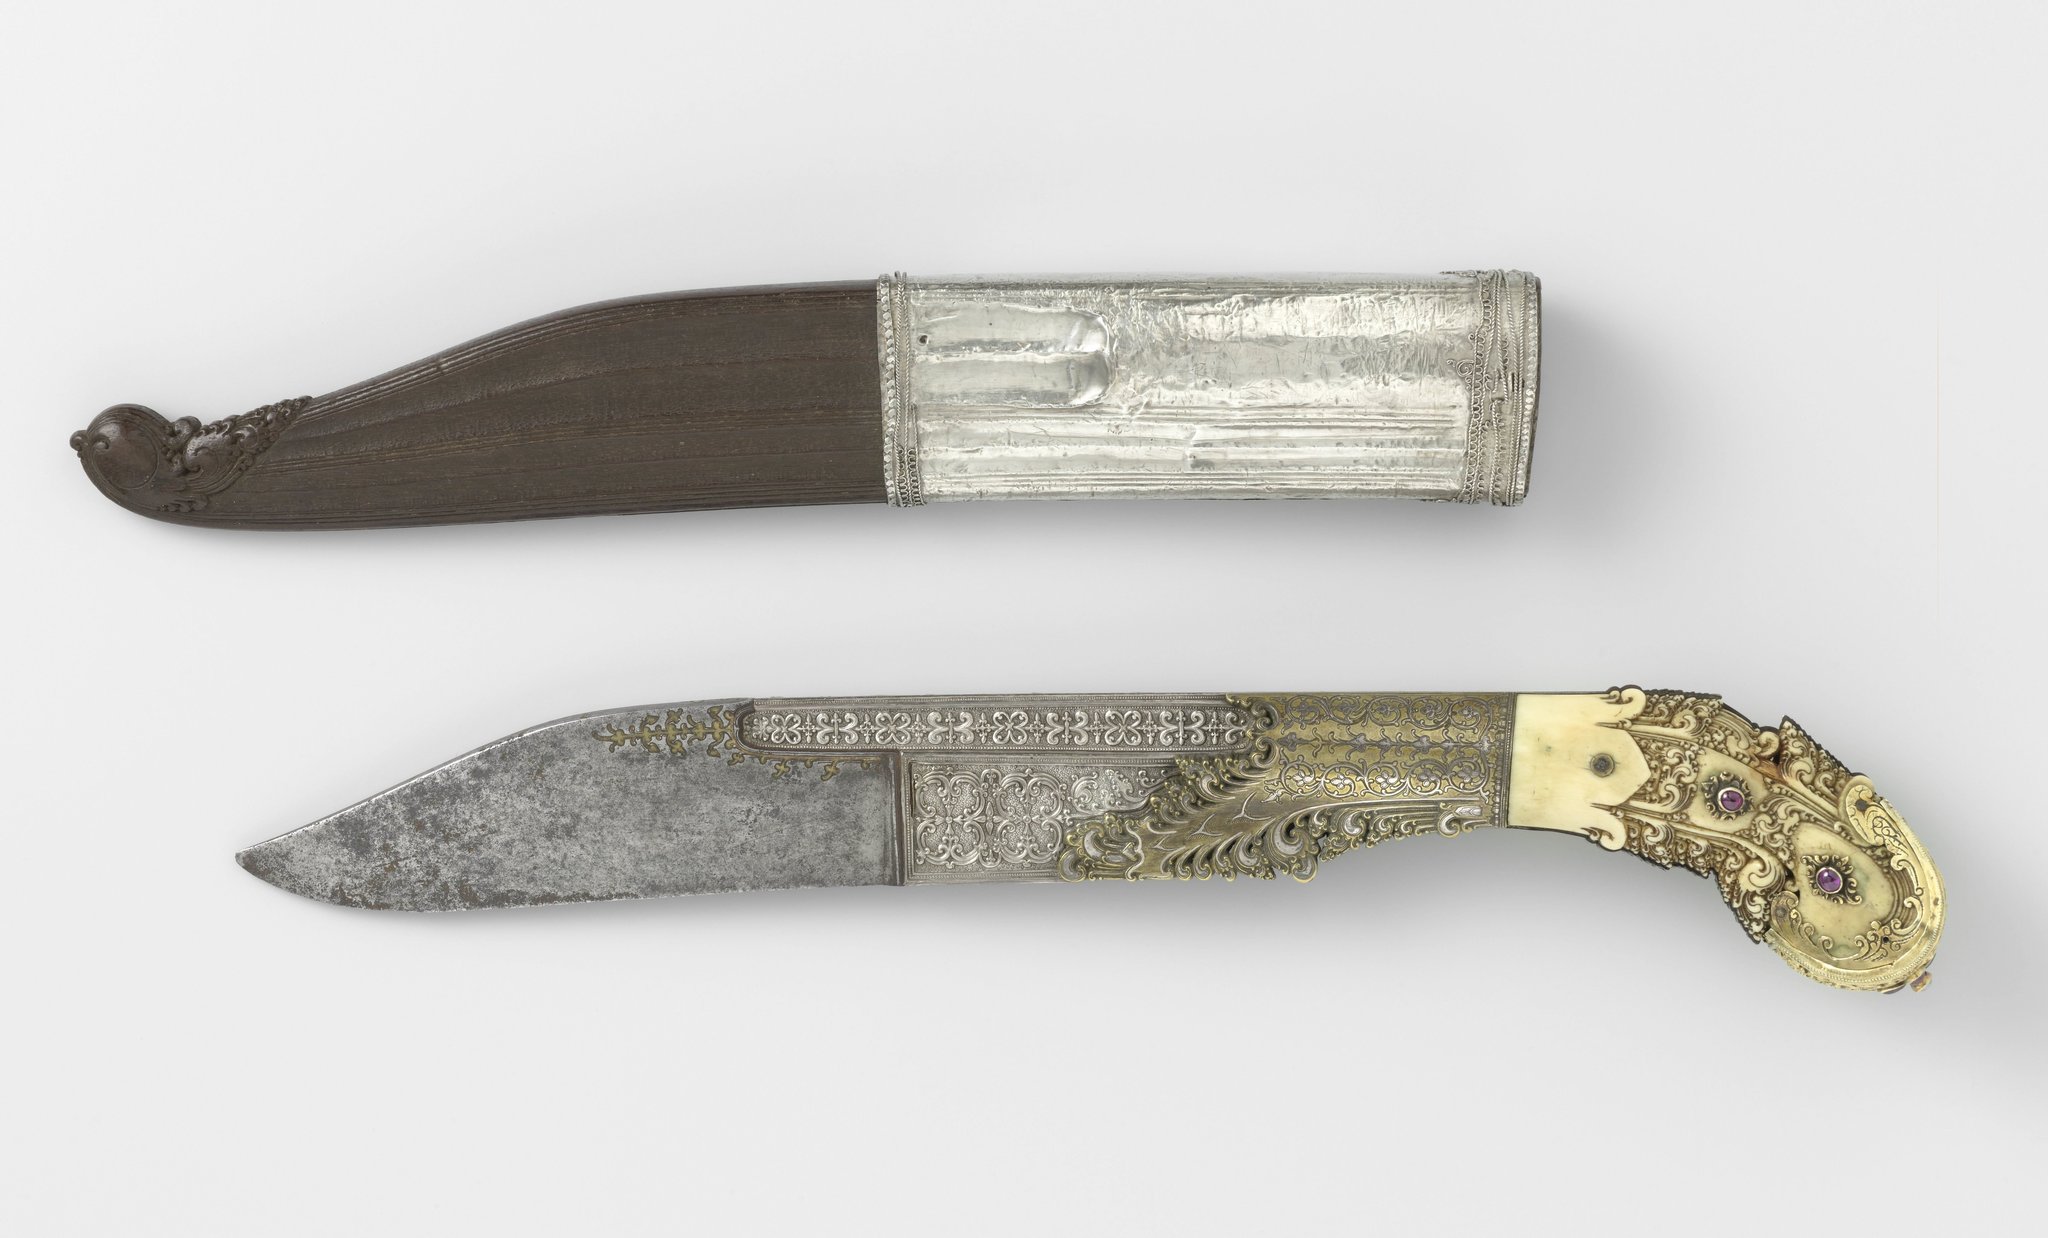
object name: machete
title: Ceremonial knife with sheath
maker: Anonymous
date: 1750-1800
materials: bronze, ivory, gemstone, steel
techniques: gilding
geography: sri lanka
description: Richly worked knives are some of the best-known collectors’ pieces from Ceylon (modern-day Sri Lanka). The finest of these were produced by members of the Four Workshops, a guild to which only the leading craftsmen belonged; these craftsmen worked almost exclusively for the court. Such knives formed part of the costumes of the aristocracy and were virtually never used.